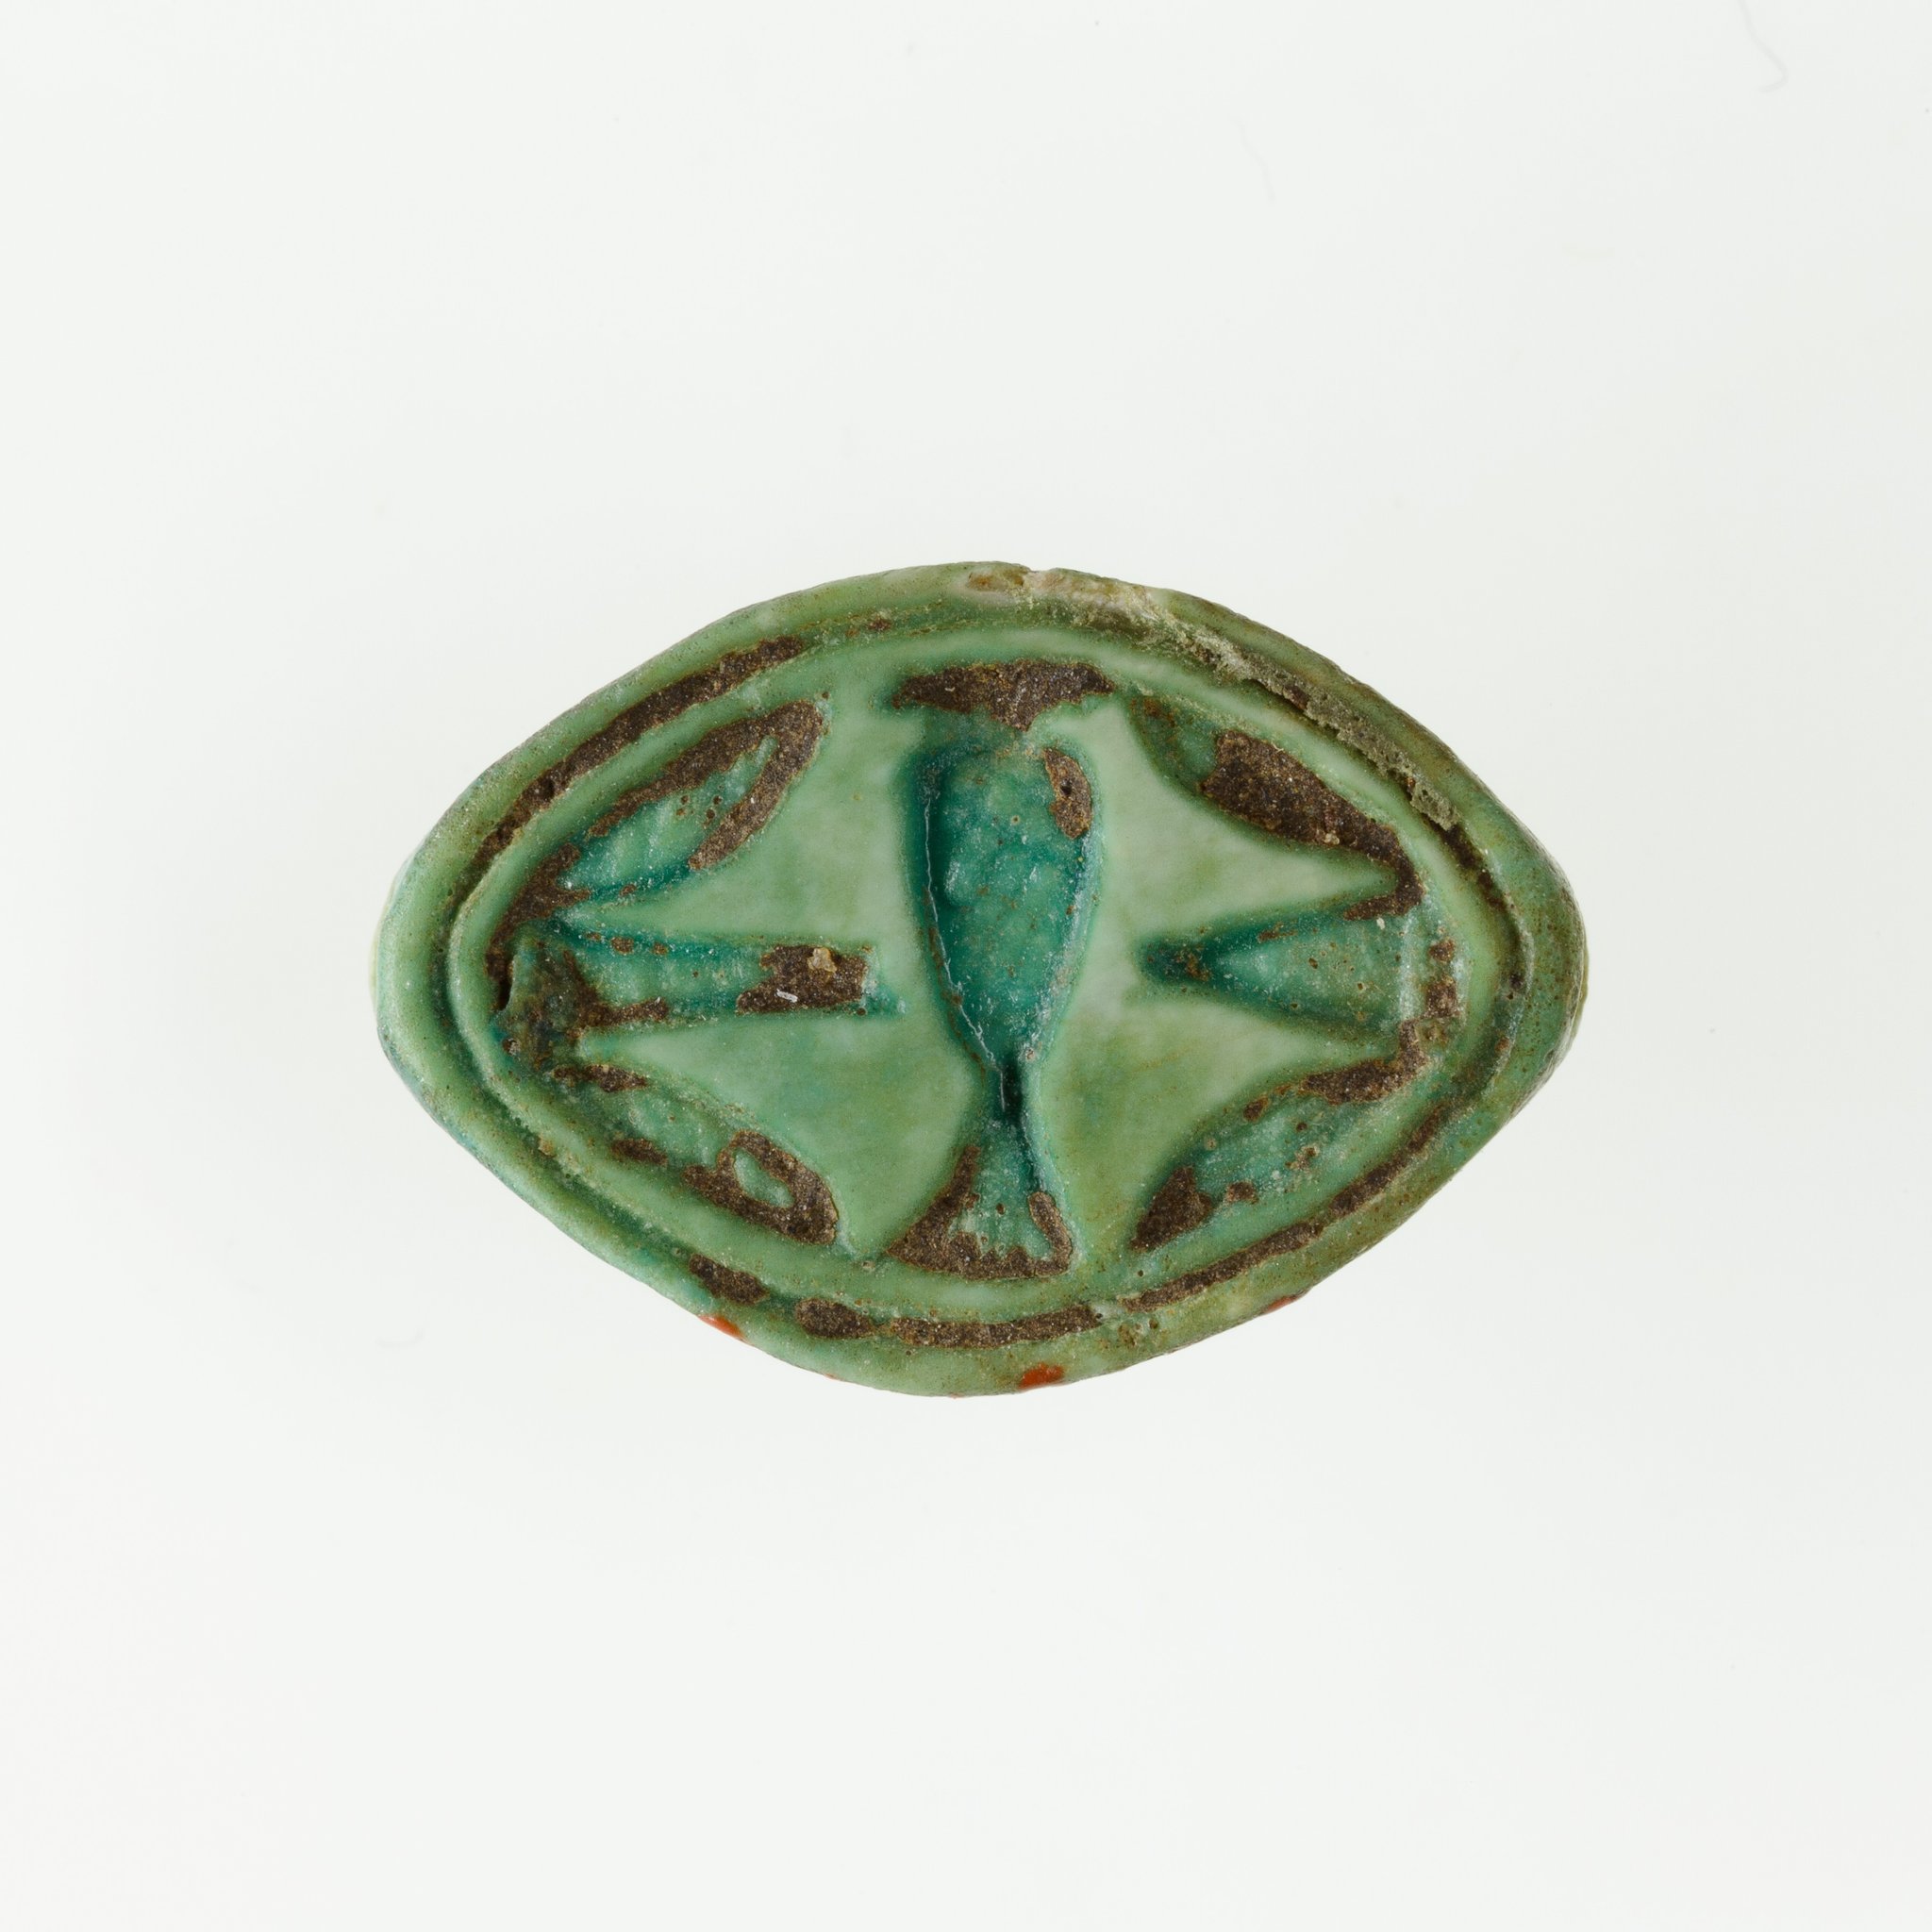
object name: cowroid, he vase, lotus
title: Cowroid Seal-Amulet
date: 1492-1473 BCE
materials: stone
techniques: glazing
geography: egypt